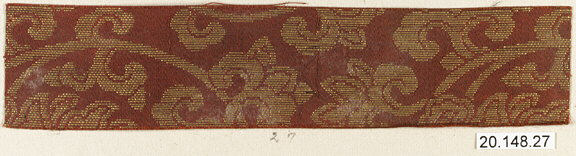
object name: piece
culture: japanese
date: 1501-1600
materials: silk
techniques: compound weave